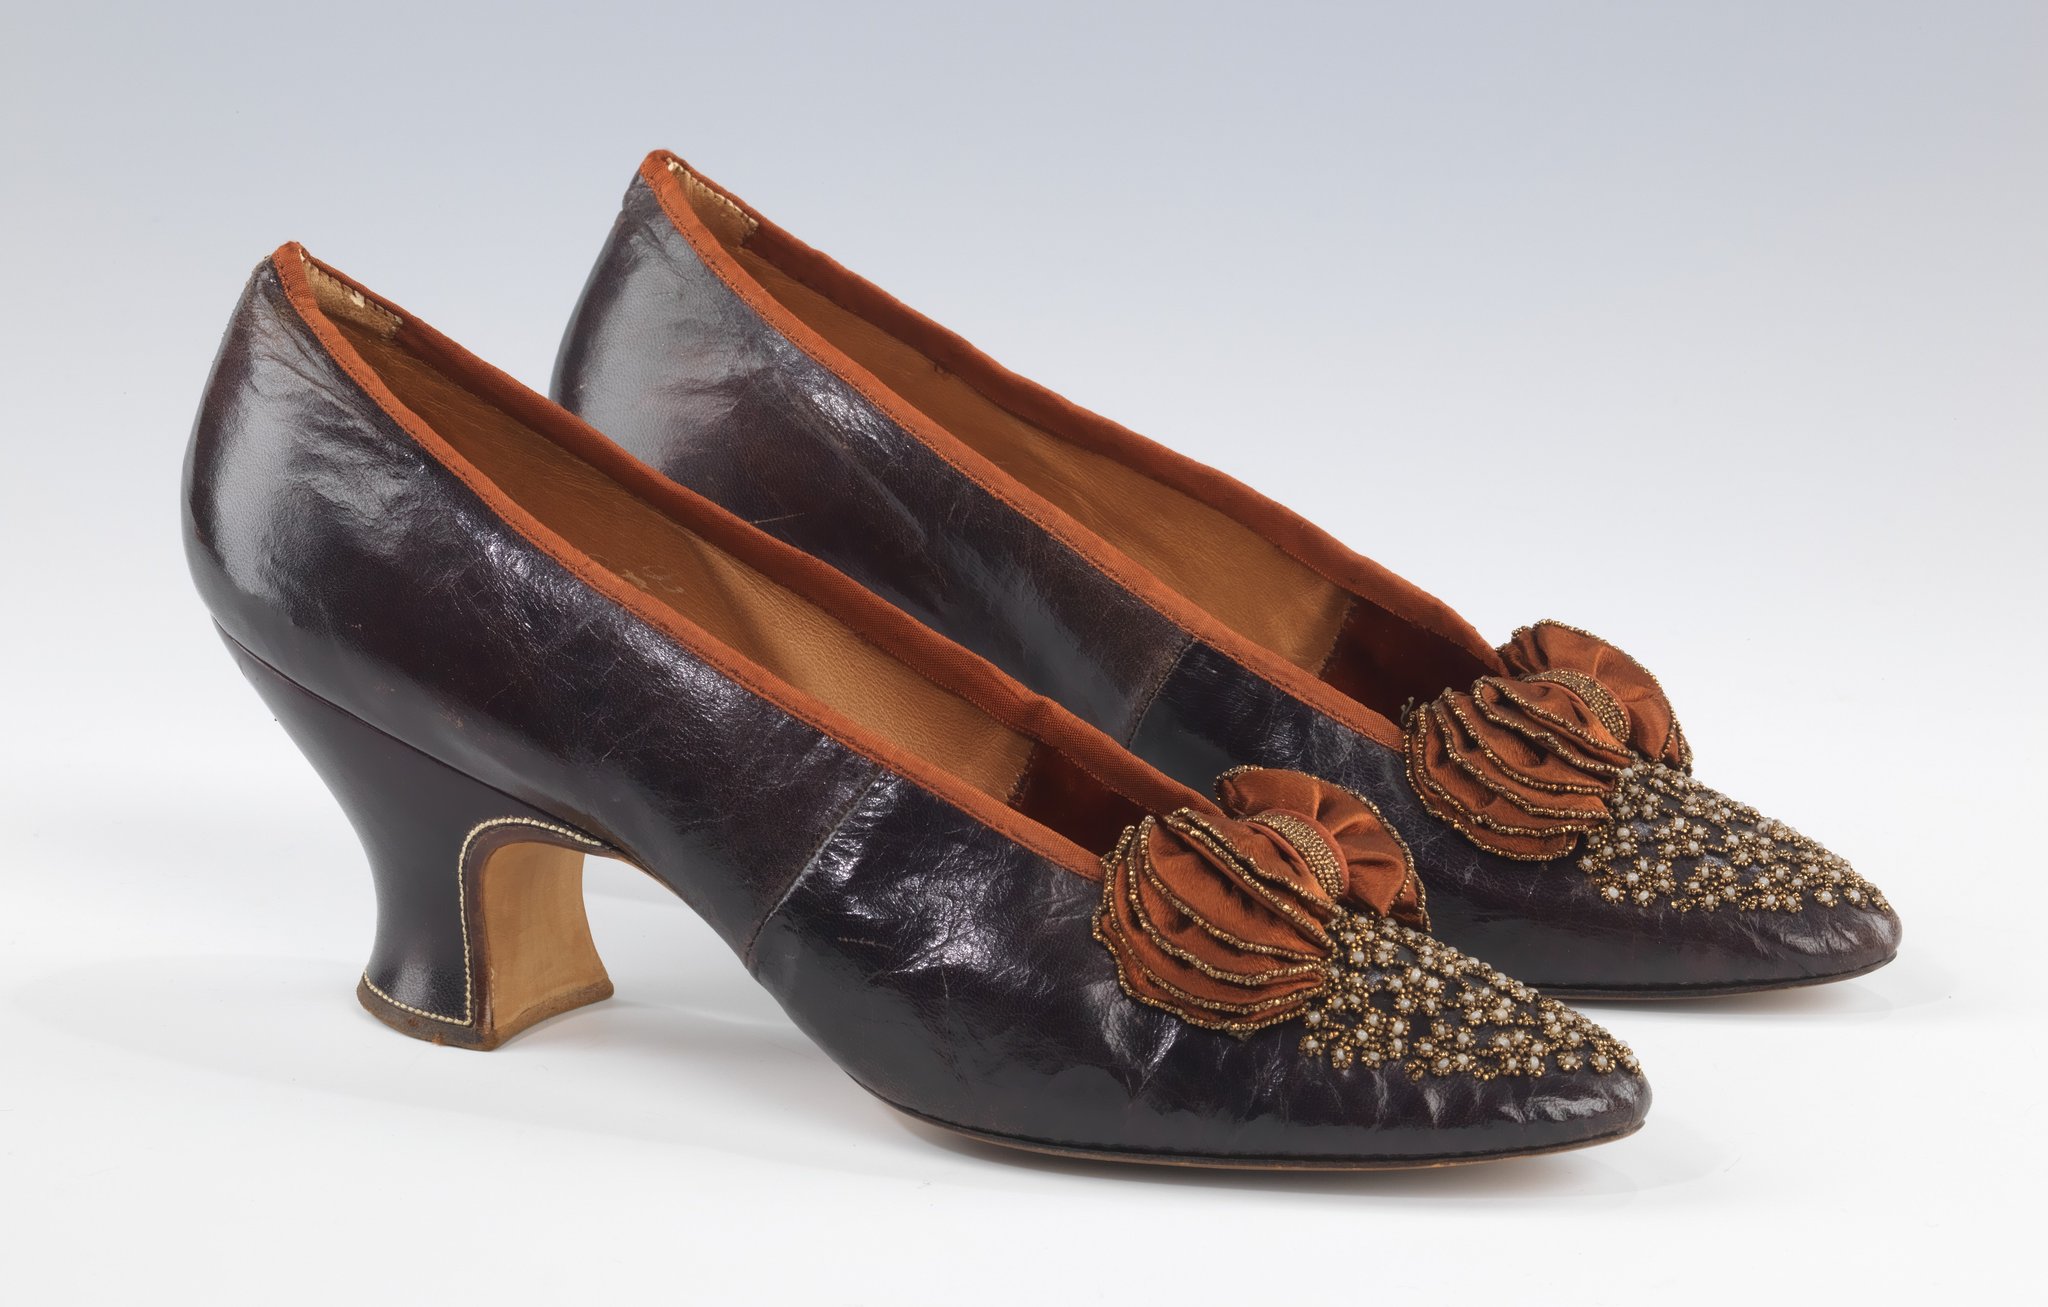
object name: evening slipper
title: Evening slippers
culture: british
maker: hook, knowles & co.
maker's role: department store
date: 1897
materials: leather, silk